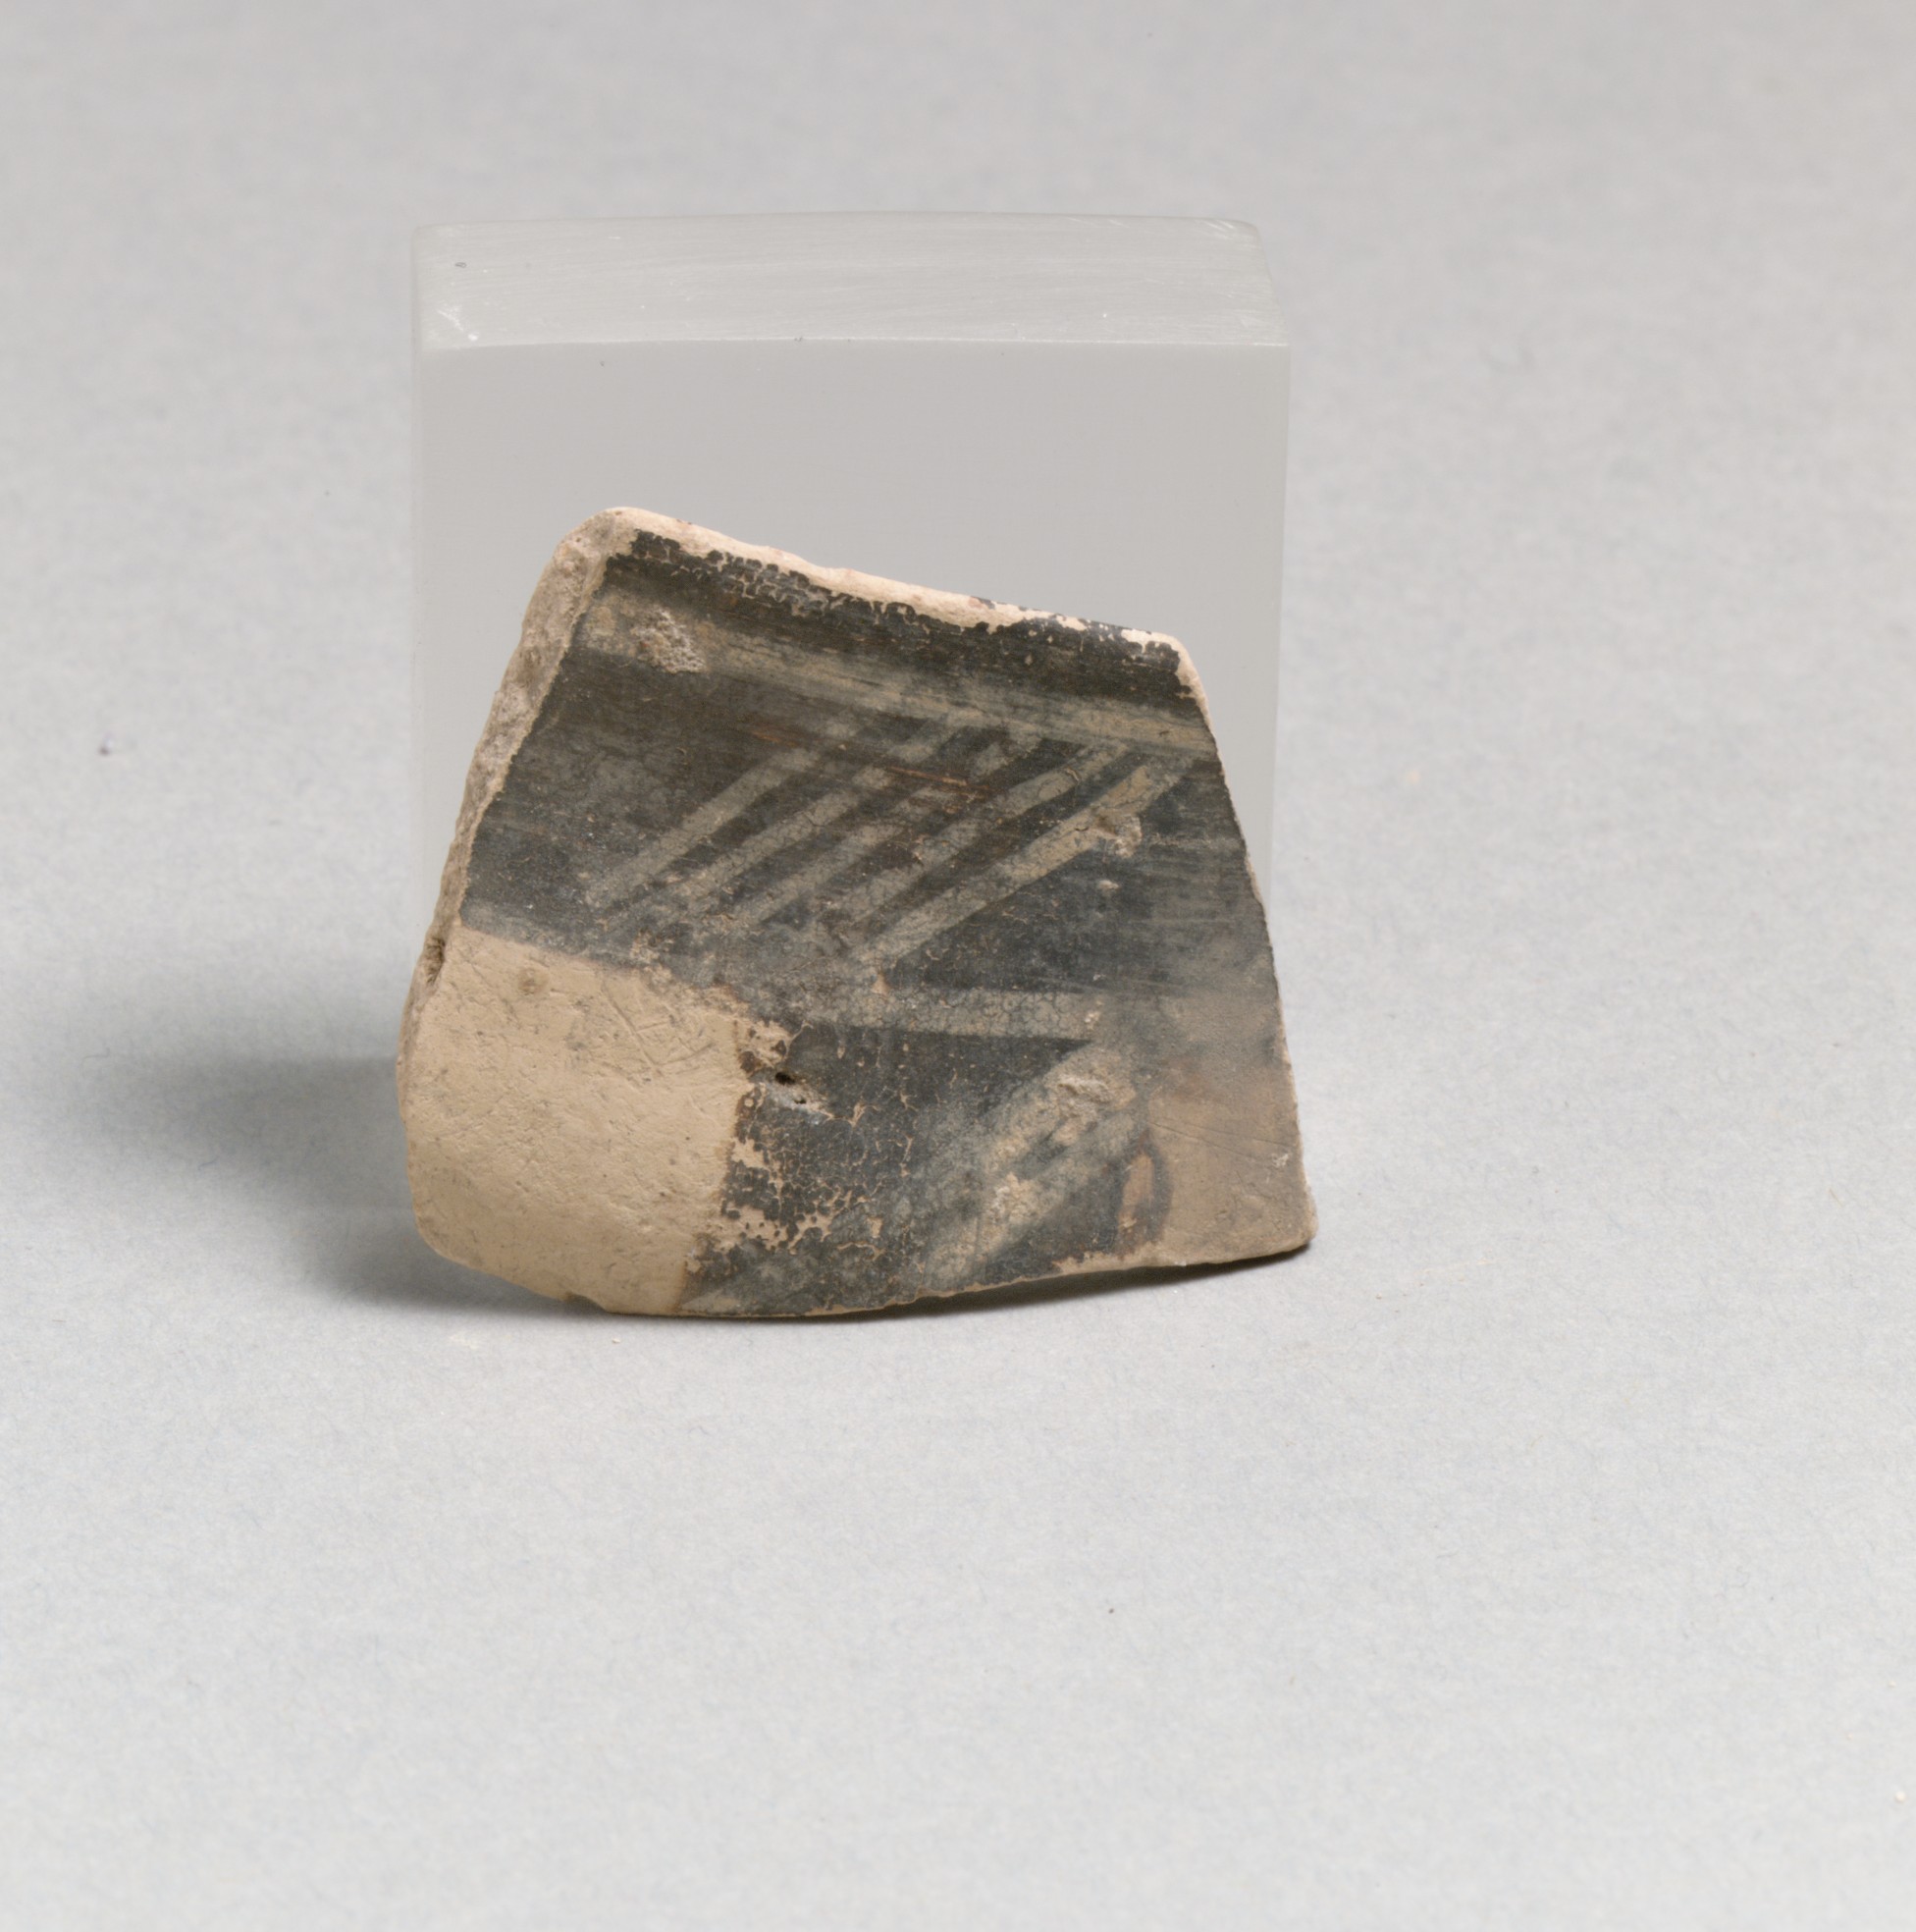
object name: vase fragment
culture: minoan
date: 2600-2000 BCE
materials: terracotta